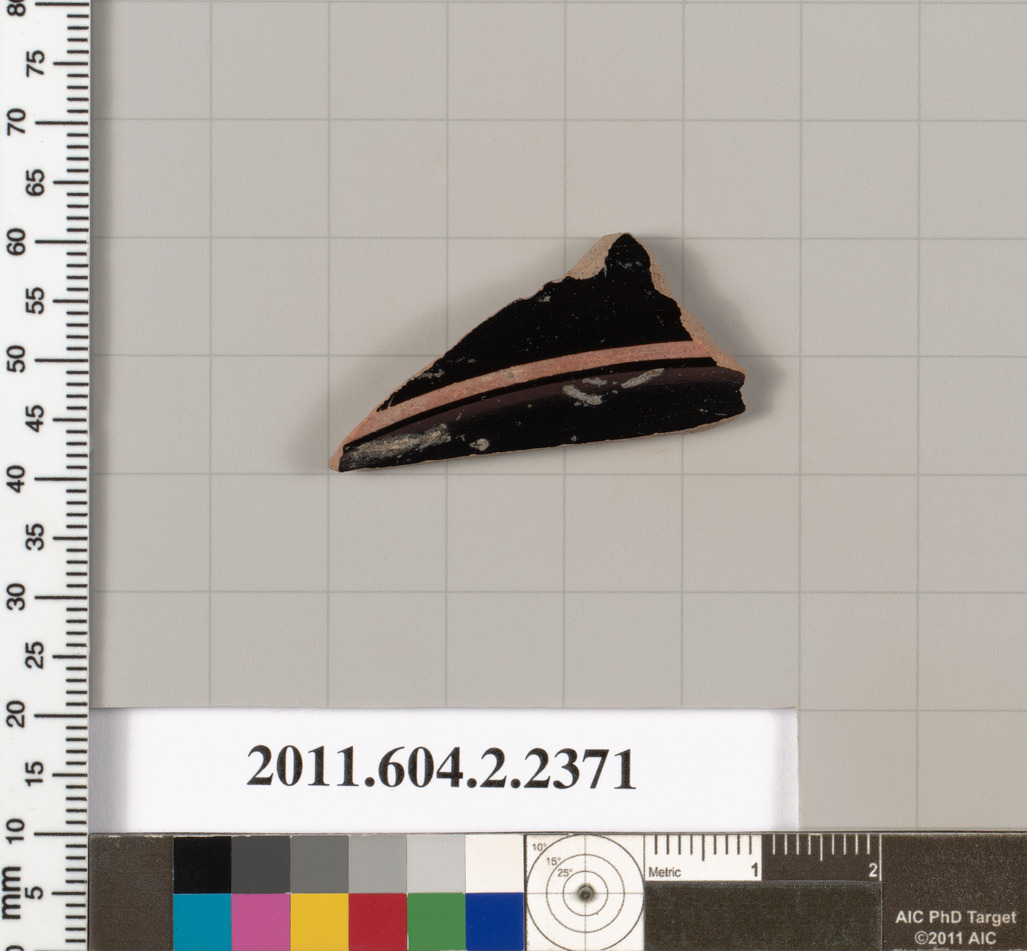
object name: pyxis fragment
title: Terracotta fragment of a pyxis (box)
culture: greek, attic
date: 475-451 BCE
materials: terracotta